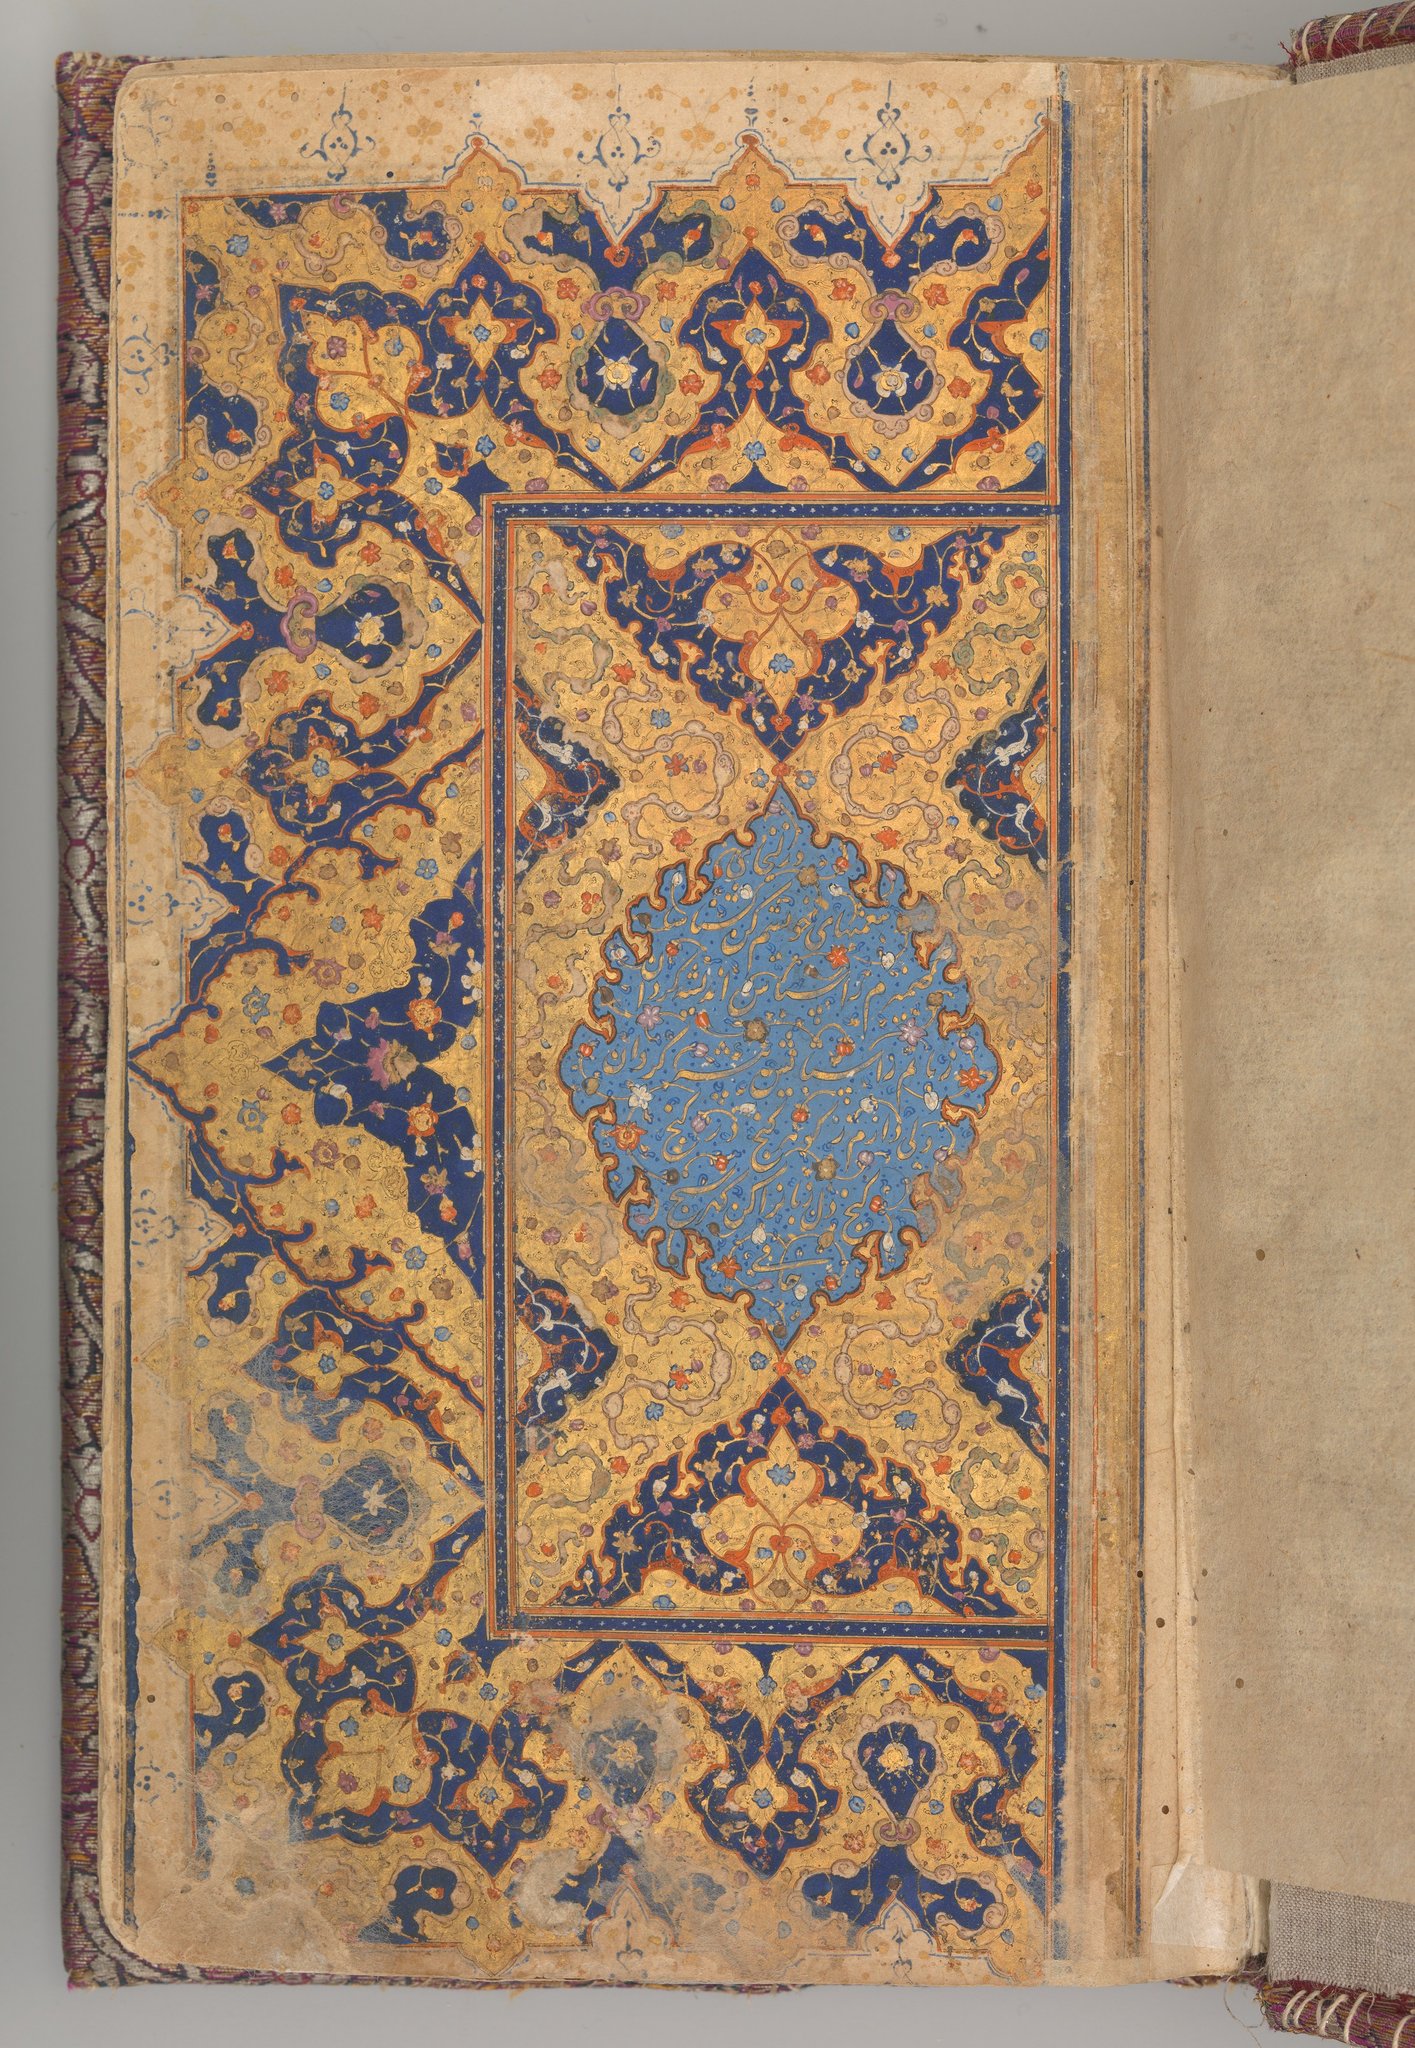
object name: bifolio from an illustrated manuscript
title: Double Page in Nasta'liq Script from a Yusuf and Zulaikha of Jami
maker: maulana nur al-din `abd al-rahman jami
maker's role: author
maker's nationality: iranian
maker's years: 1414-1492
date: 1551-1600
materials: gold, ink, paper, watercolor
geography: iran